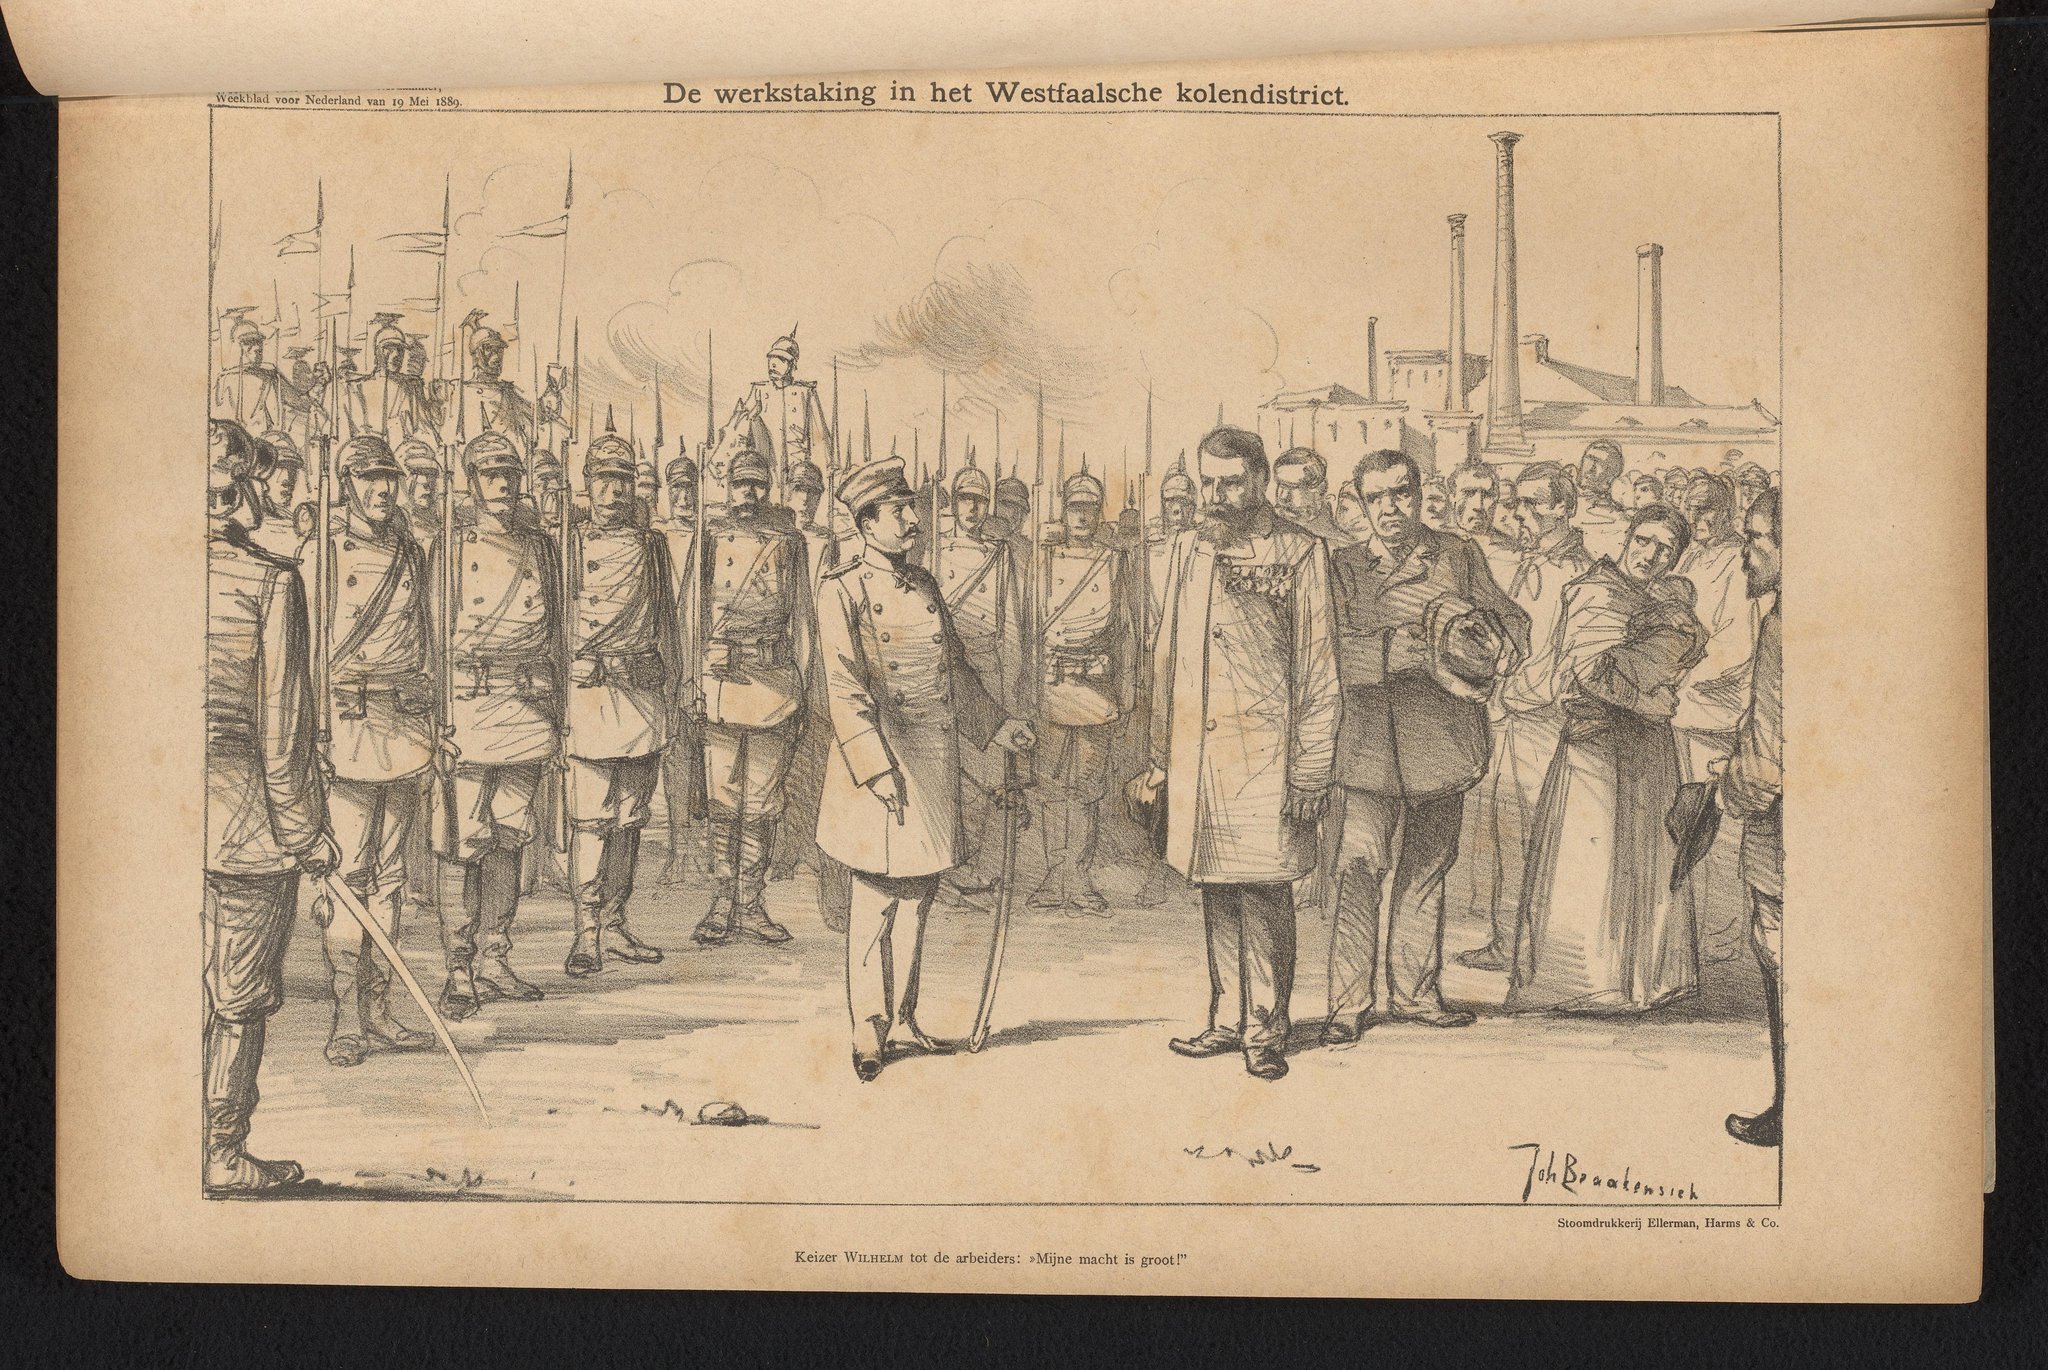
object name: cartoon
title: De werkstaking in het Westfaalsche kolendistrict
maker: johan braakensiek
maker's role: draughtsman, print maker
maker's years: 1858-1940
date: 1889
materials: paper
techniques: lithograph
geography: amsterdam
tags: wilhelm ii (keizer van duitsland), strike (political demonstration), political caricatures and satires, westphalia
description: De Duitse keizer Wilhelm II aan het hoofd van een groot legermacht tegenover de stakende arbeiders van de kolenmijnen in Westfalen en hun gezinnen.